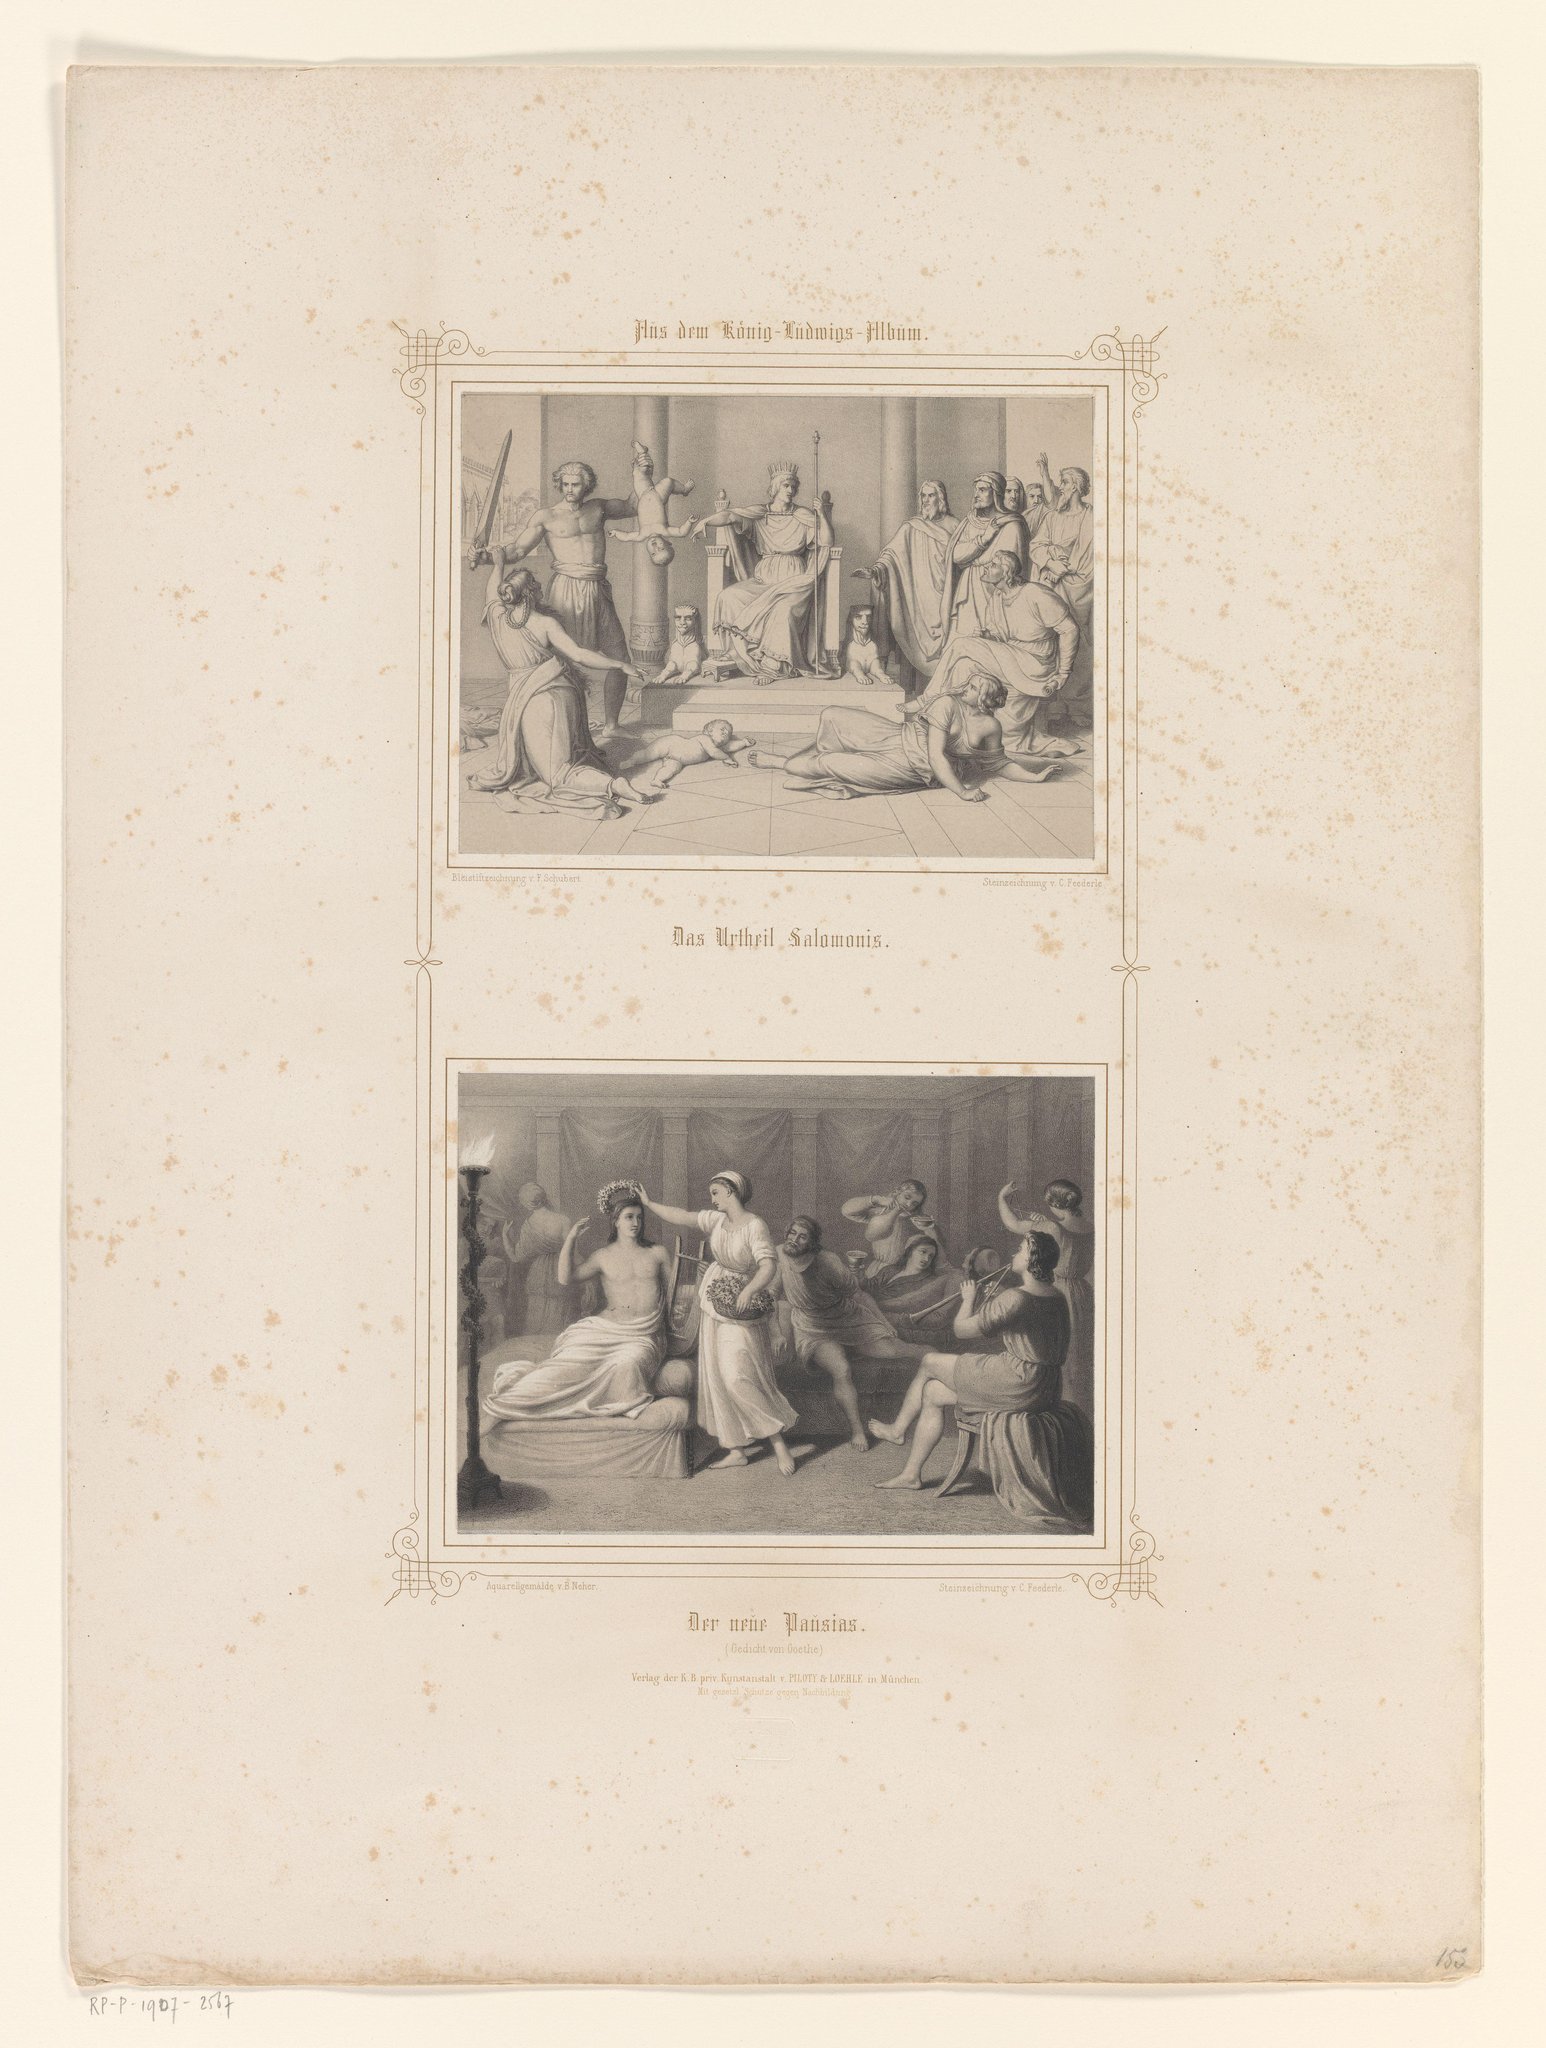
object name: print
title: Der neue Pausias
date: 1850-1859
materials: paper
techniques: tone lithography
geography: munich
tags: the judgement of solomon (1 kings 3:16-28), pausias and his mistress glycera, whom he depicted sitting on the ground and making garlands of flowers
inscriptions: collector's mark: Lugt 2228, check stamp: ‘Piloty&Loehle, München’, : ‘Mit gesetzl Schutze gegen Nachbildung’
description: Prent afkomstig uit de serie 'Album Seiner Majestät des Königs Ludwig I. von Bayern', verschenen in verschillende afleveringen. De prenten gaan terug op het album dat Lodewijk I van Beieren op 9 oktober 1850 kreeg overhandigd van verschillende kunstenaars.